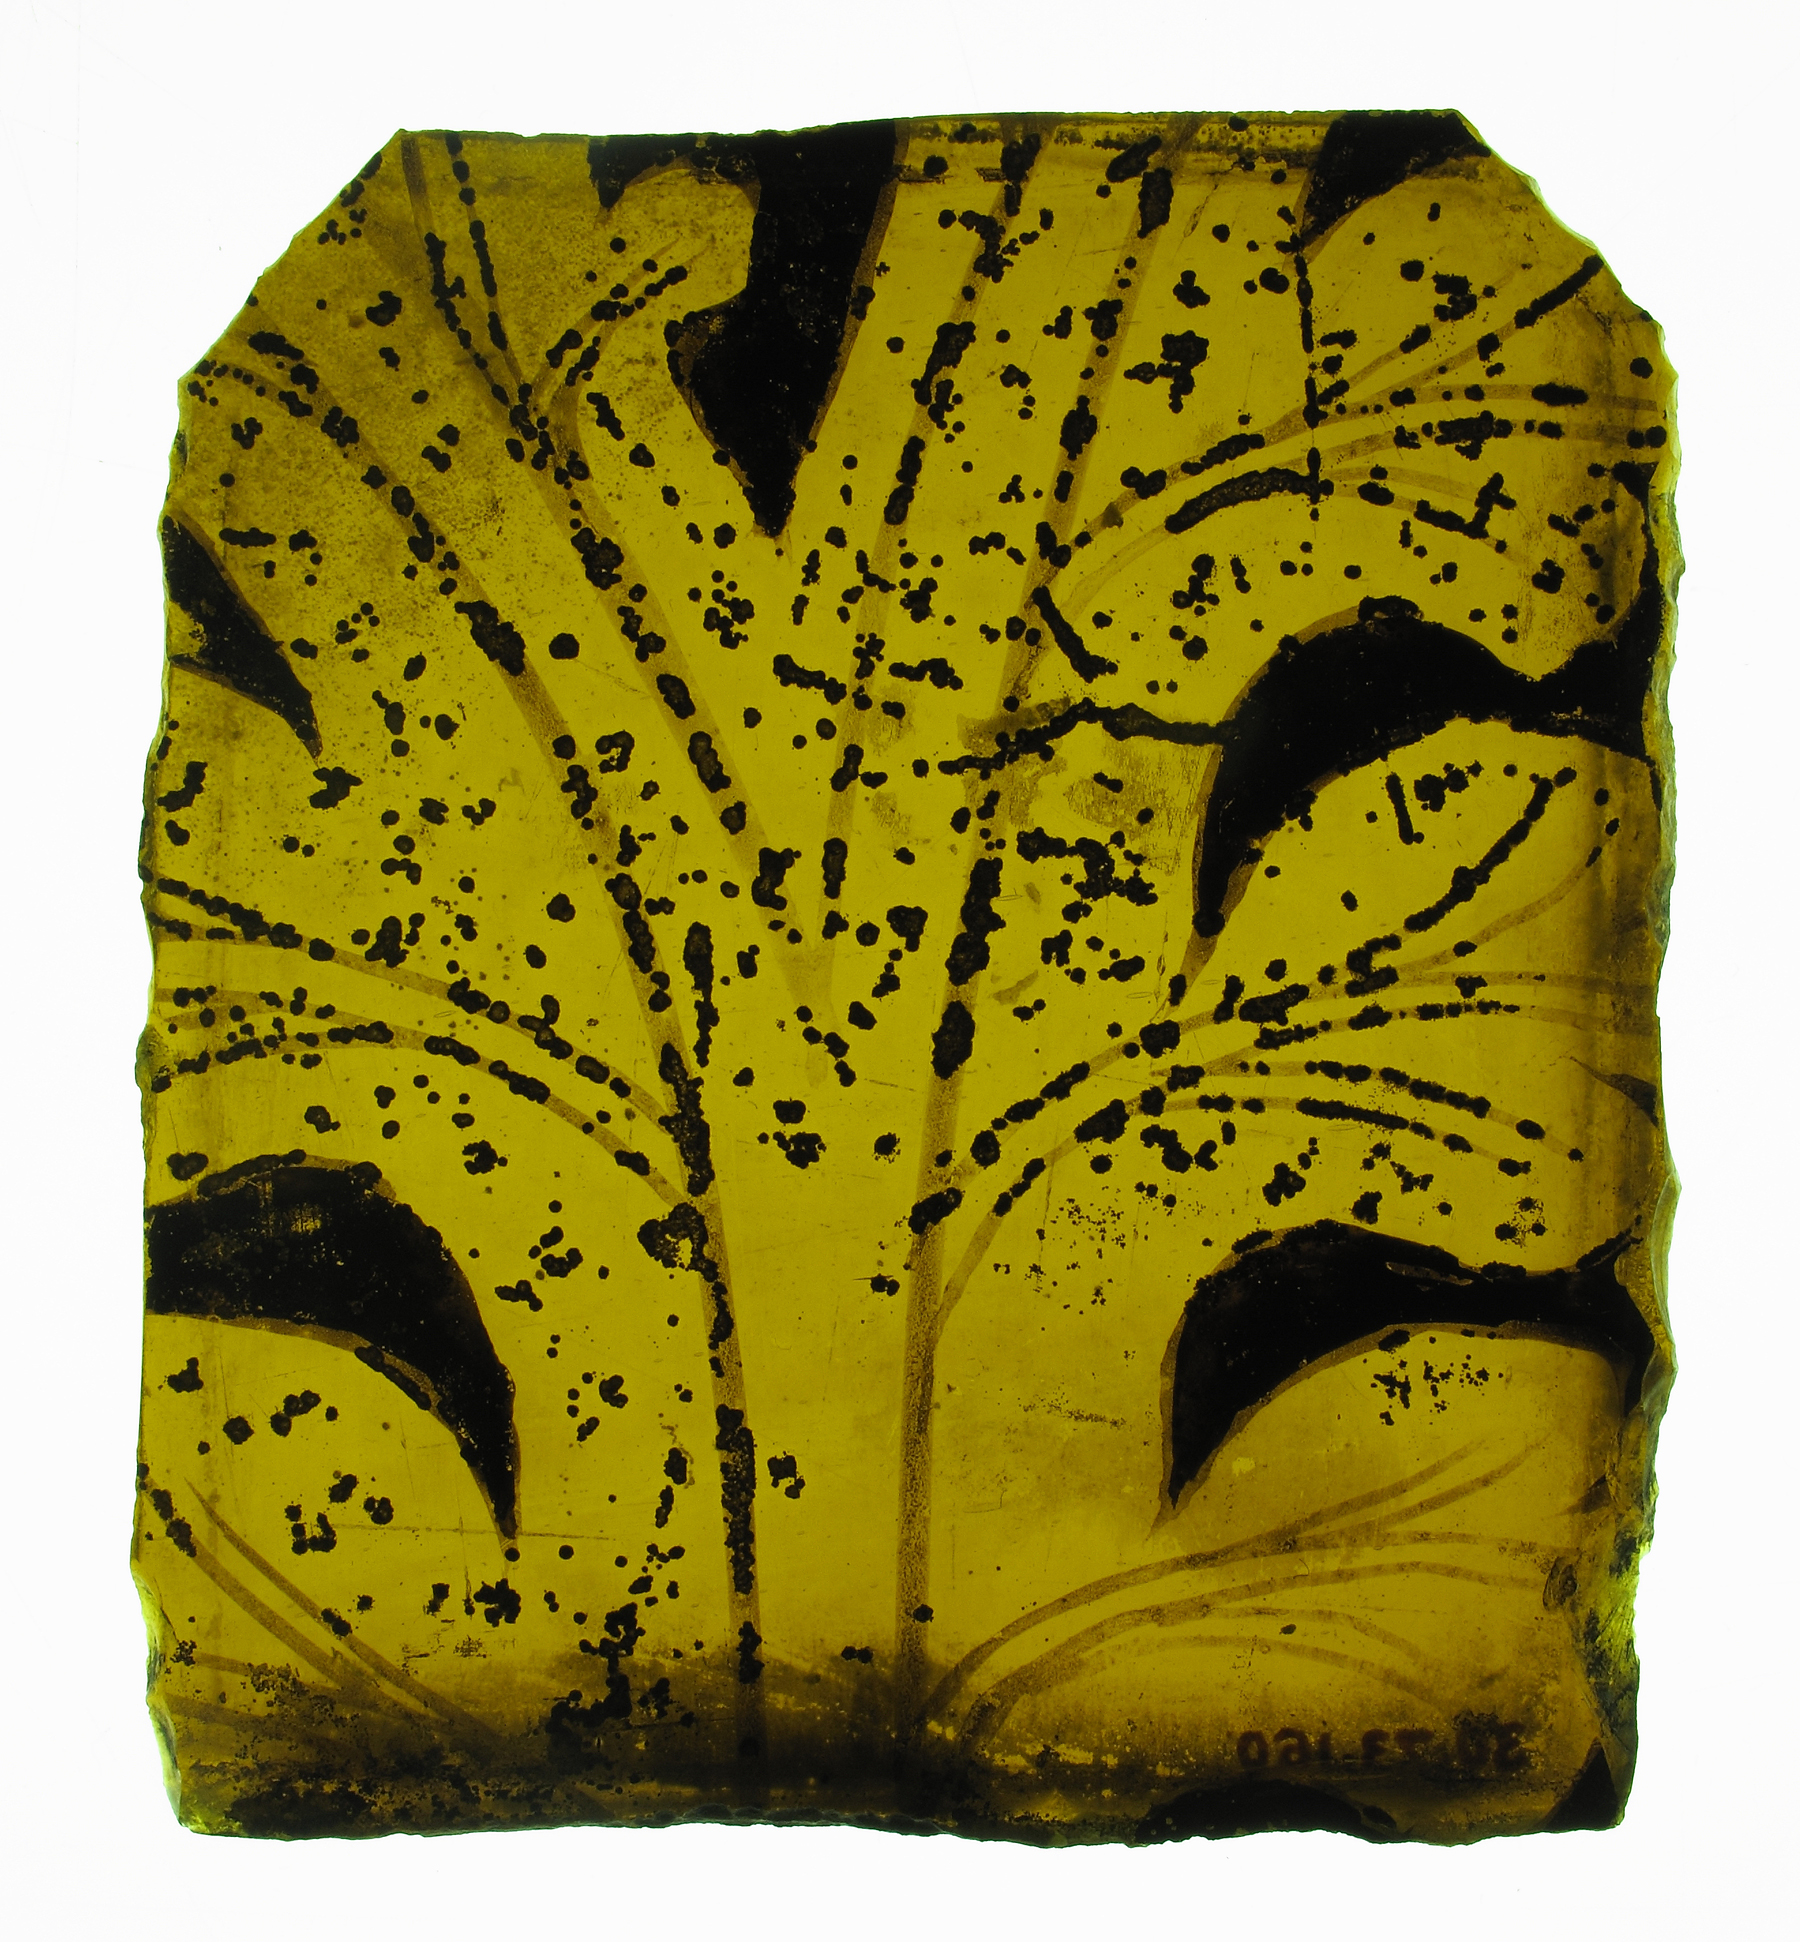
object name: fragment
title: Glass Fragment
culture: european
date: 1301-1400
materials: glass, metal